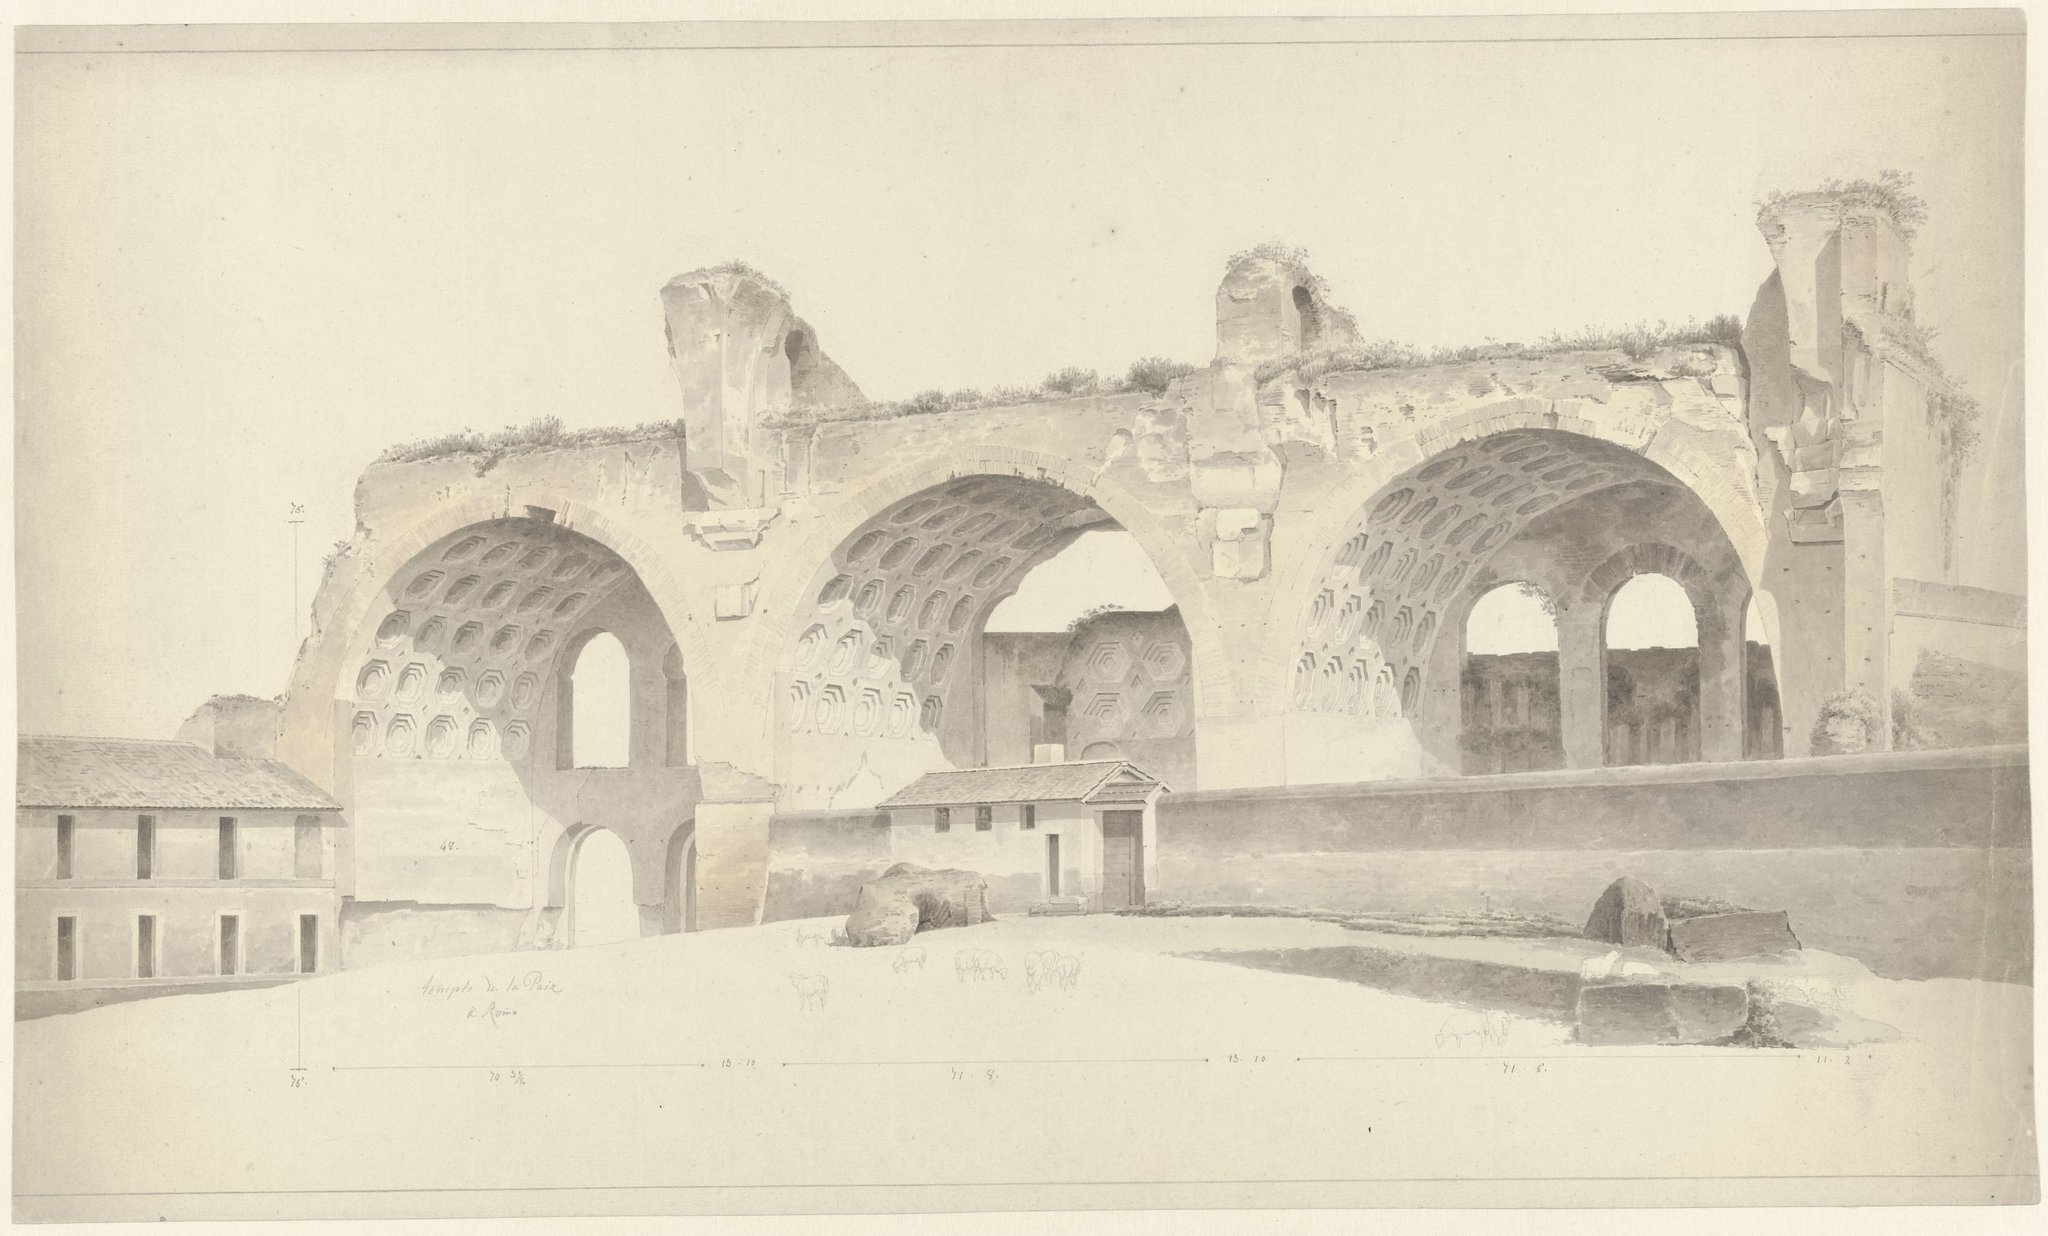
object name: drawing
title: The Basilica of Maxentius and Constantine in Rome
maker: josephus augustus knip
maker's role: draughtsman, painter, print maker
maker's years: 1777-1847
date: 1809-1812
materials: graphite, paper, watercolor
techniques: brush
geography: italy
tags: ruin of a building ~ architecture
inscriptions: inscription: ‘temple de la Paix / à Rome’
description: The gigantic, 4th-century AD building was used for judicial cases and by Romans settling private financial matters. In Knip’s time, it was known as Il Tempio della Pace (the Temple of Peace), the name he inscribed on the drawing. A view from the same vantage point is on display in the adjacent gallery; this is the only known case of two virtually identical views by Knip of the same motif.